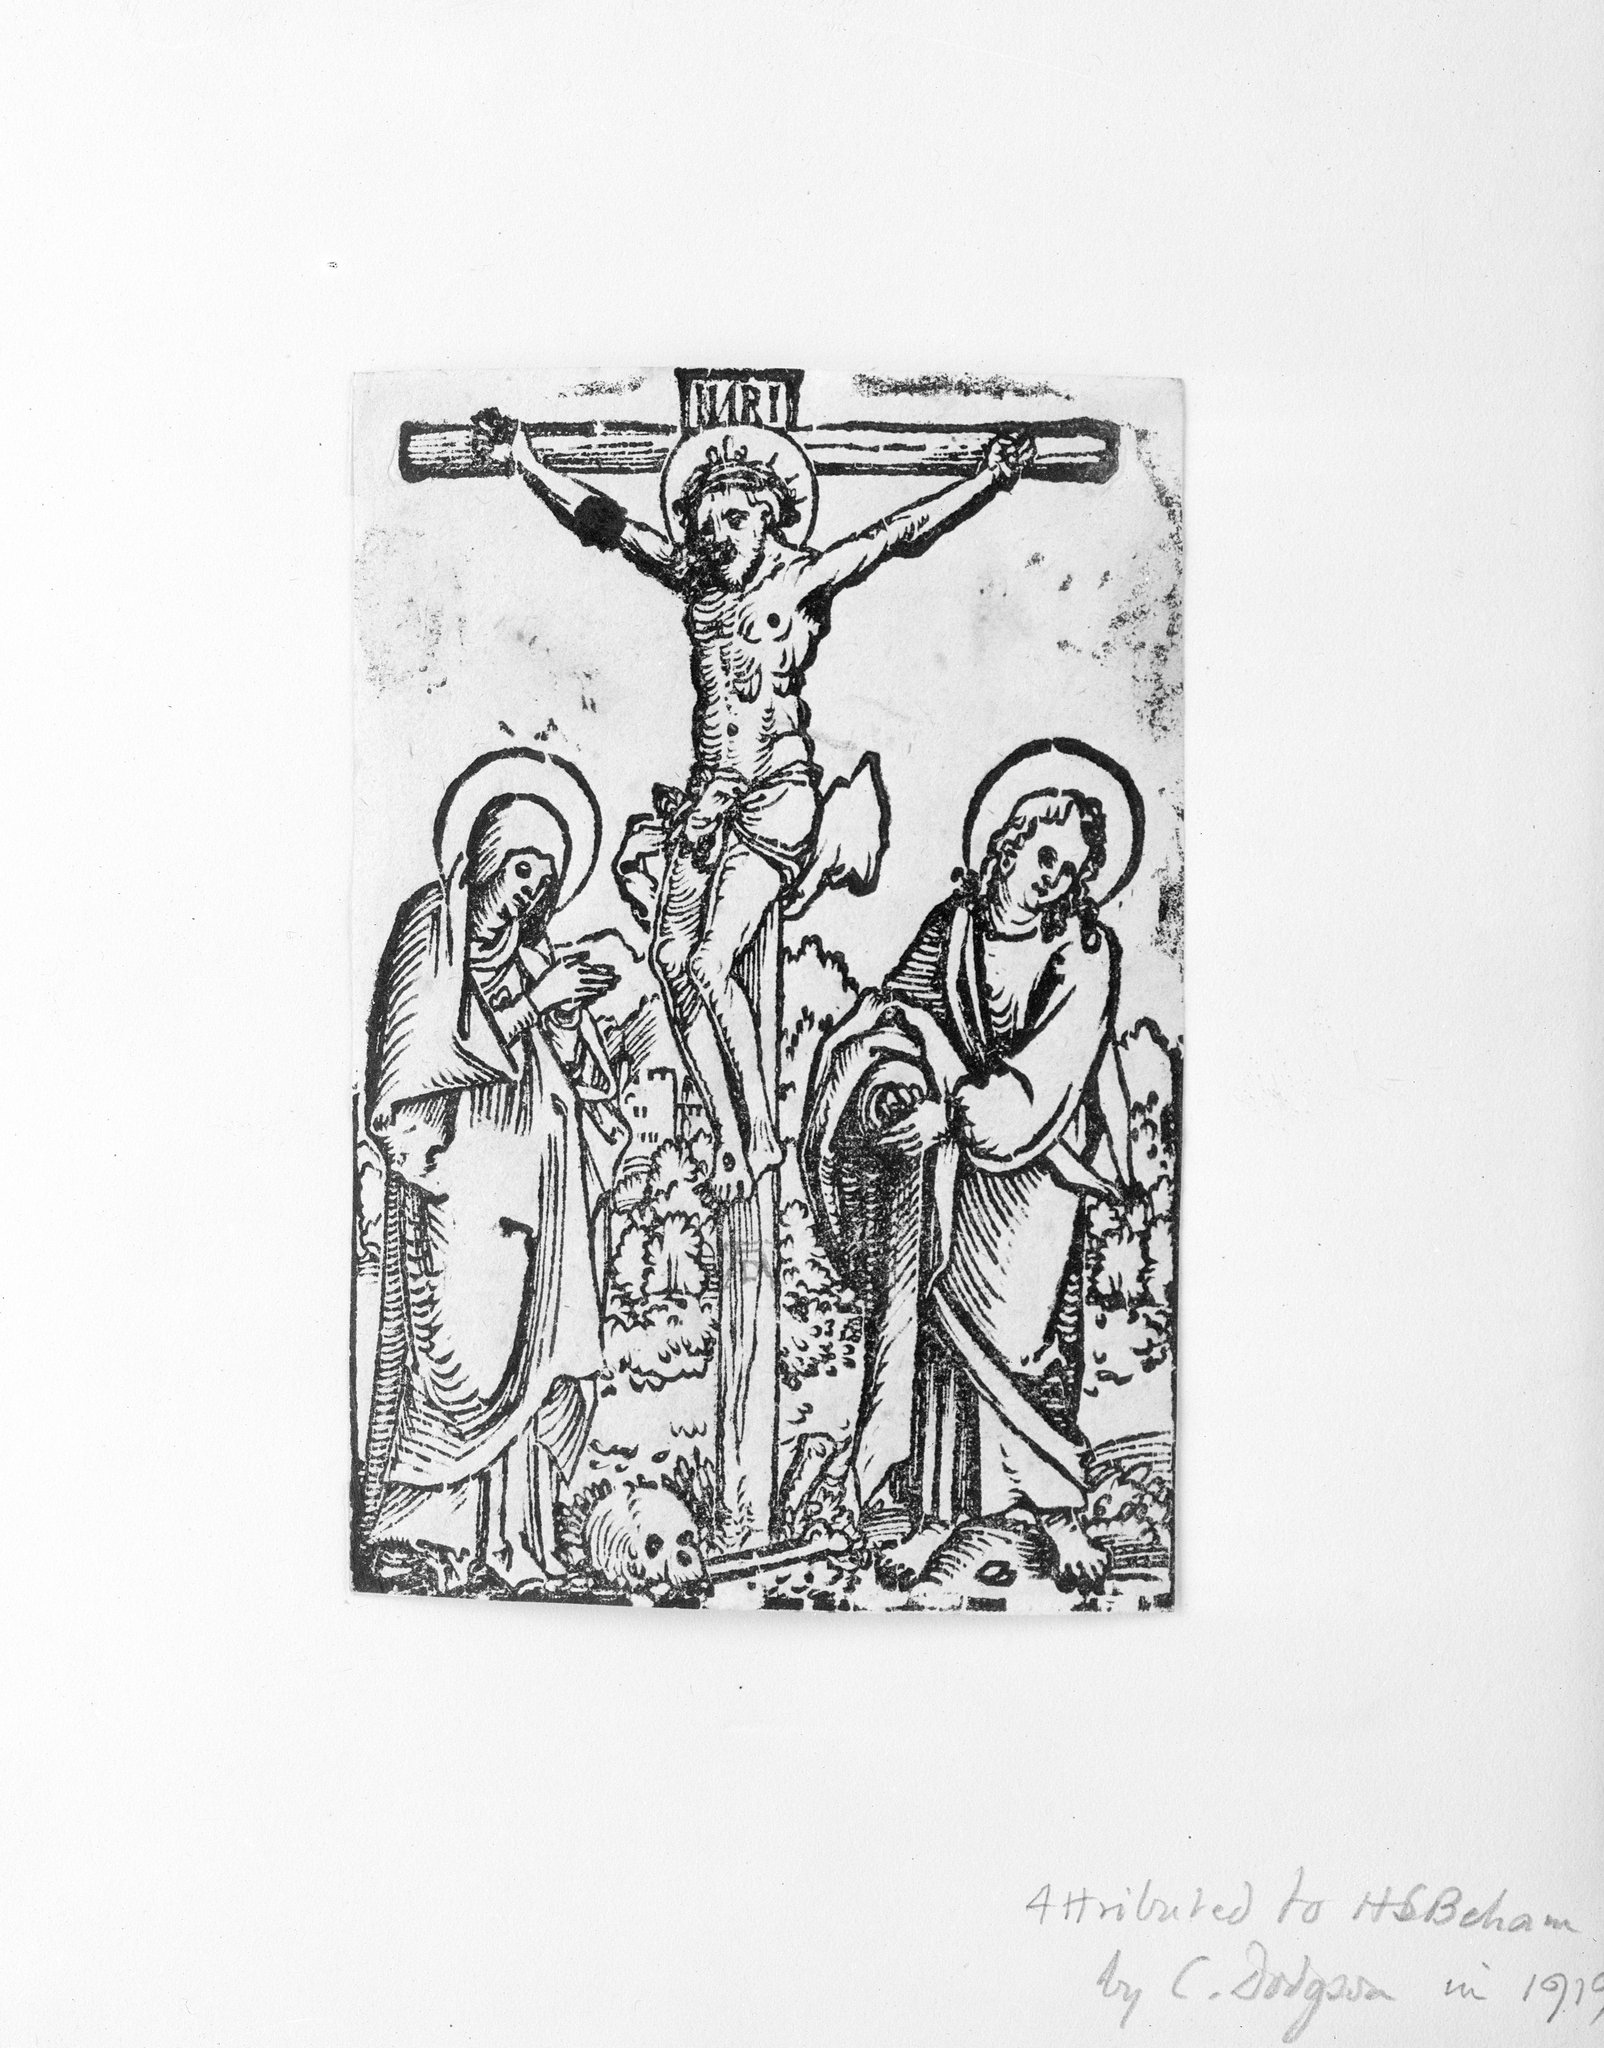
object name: print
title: The Crucifixion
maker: sebald beham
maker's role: artist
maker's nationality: german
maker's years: 1500-1550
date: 1521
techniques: woodcut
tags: men,women,christ,crucifixion